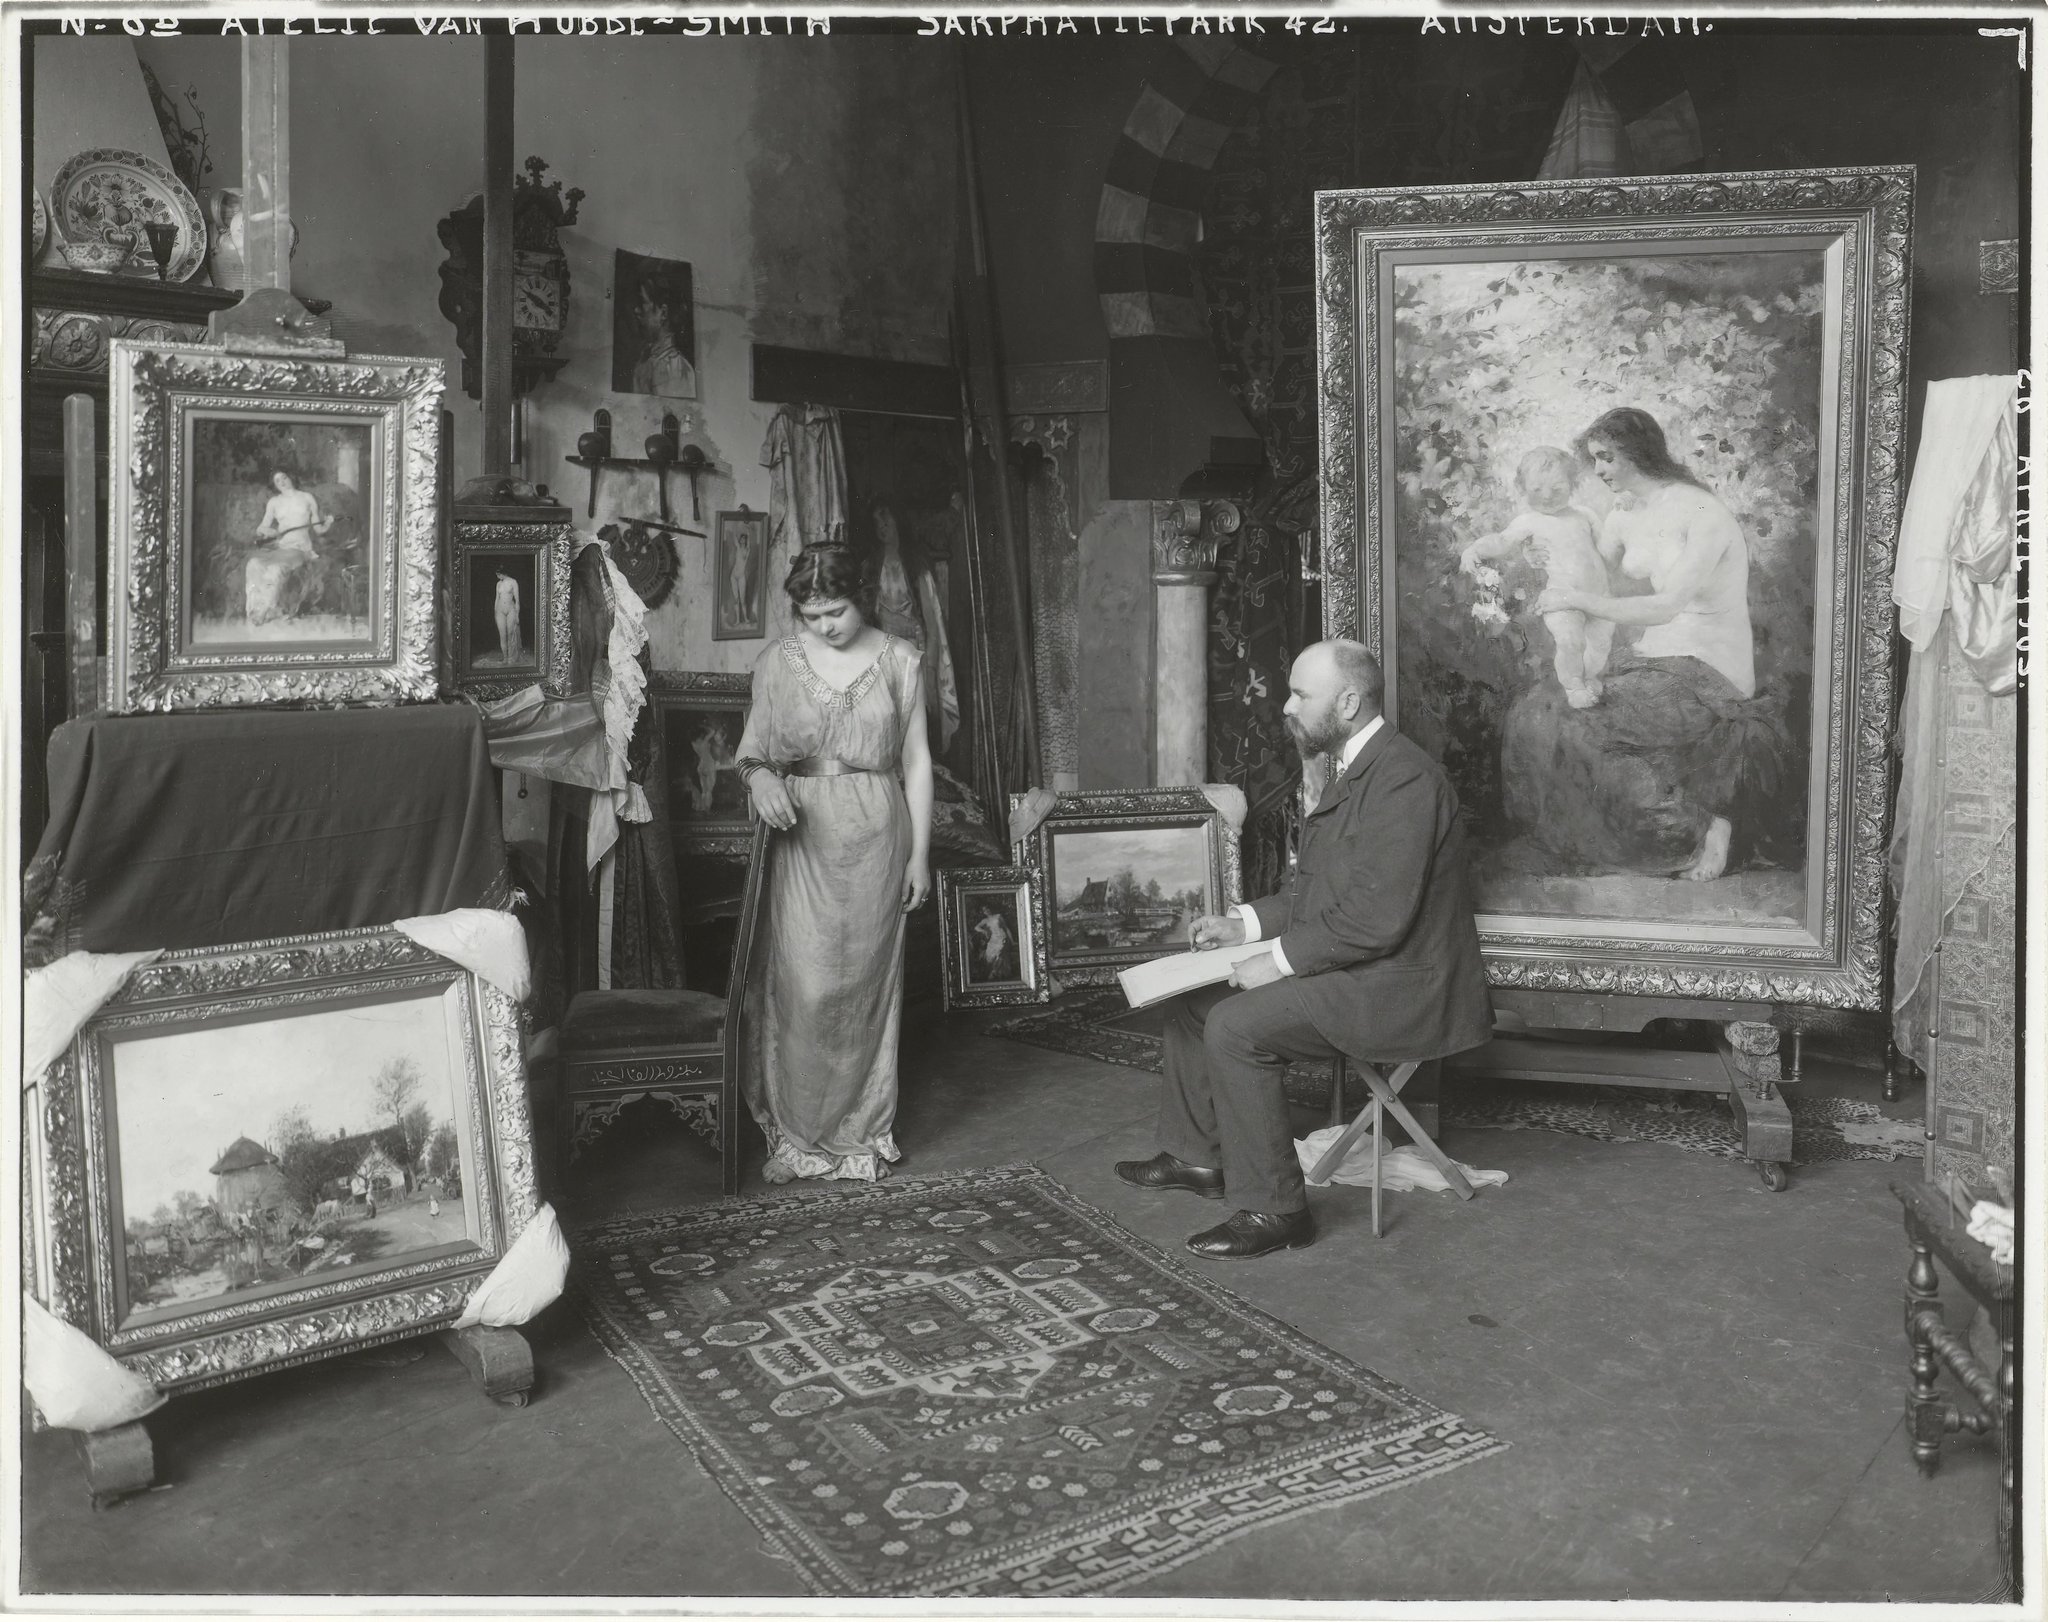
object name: photograph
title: Schilder Hobbe Smith met een model in zijn atelier aan het Sarphatipark 42, Amsterdam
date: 1903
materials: paper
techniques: gelatin silver print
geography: amsterdam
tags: amsterdam, painter, hobbe smith, the painter and his muse, painter at work, in his studio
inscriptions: inscription: ‘No 8b ATELIE VAN HOBBE-SMITH SARPHATIPARK 42 AMSTERDAM’, copyright notice: ‘world copyright by W.M.A. Deppe’